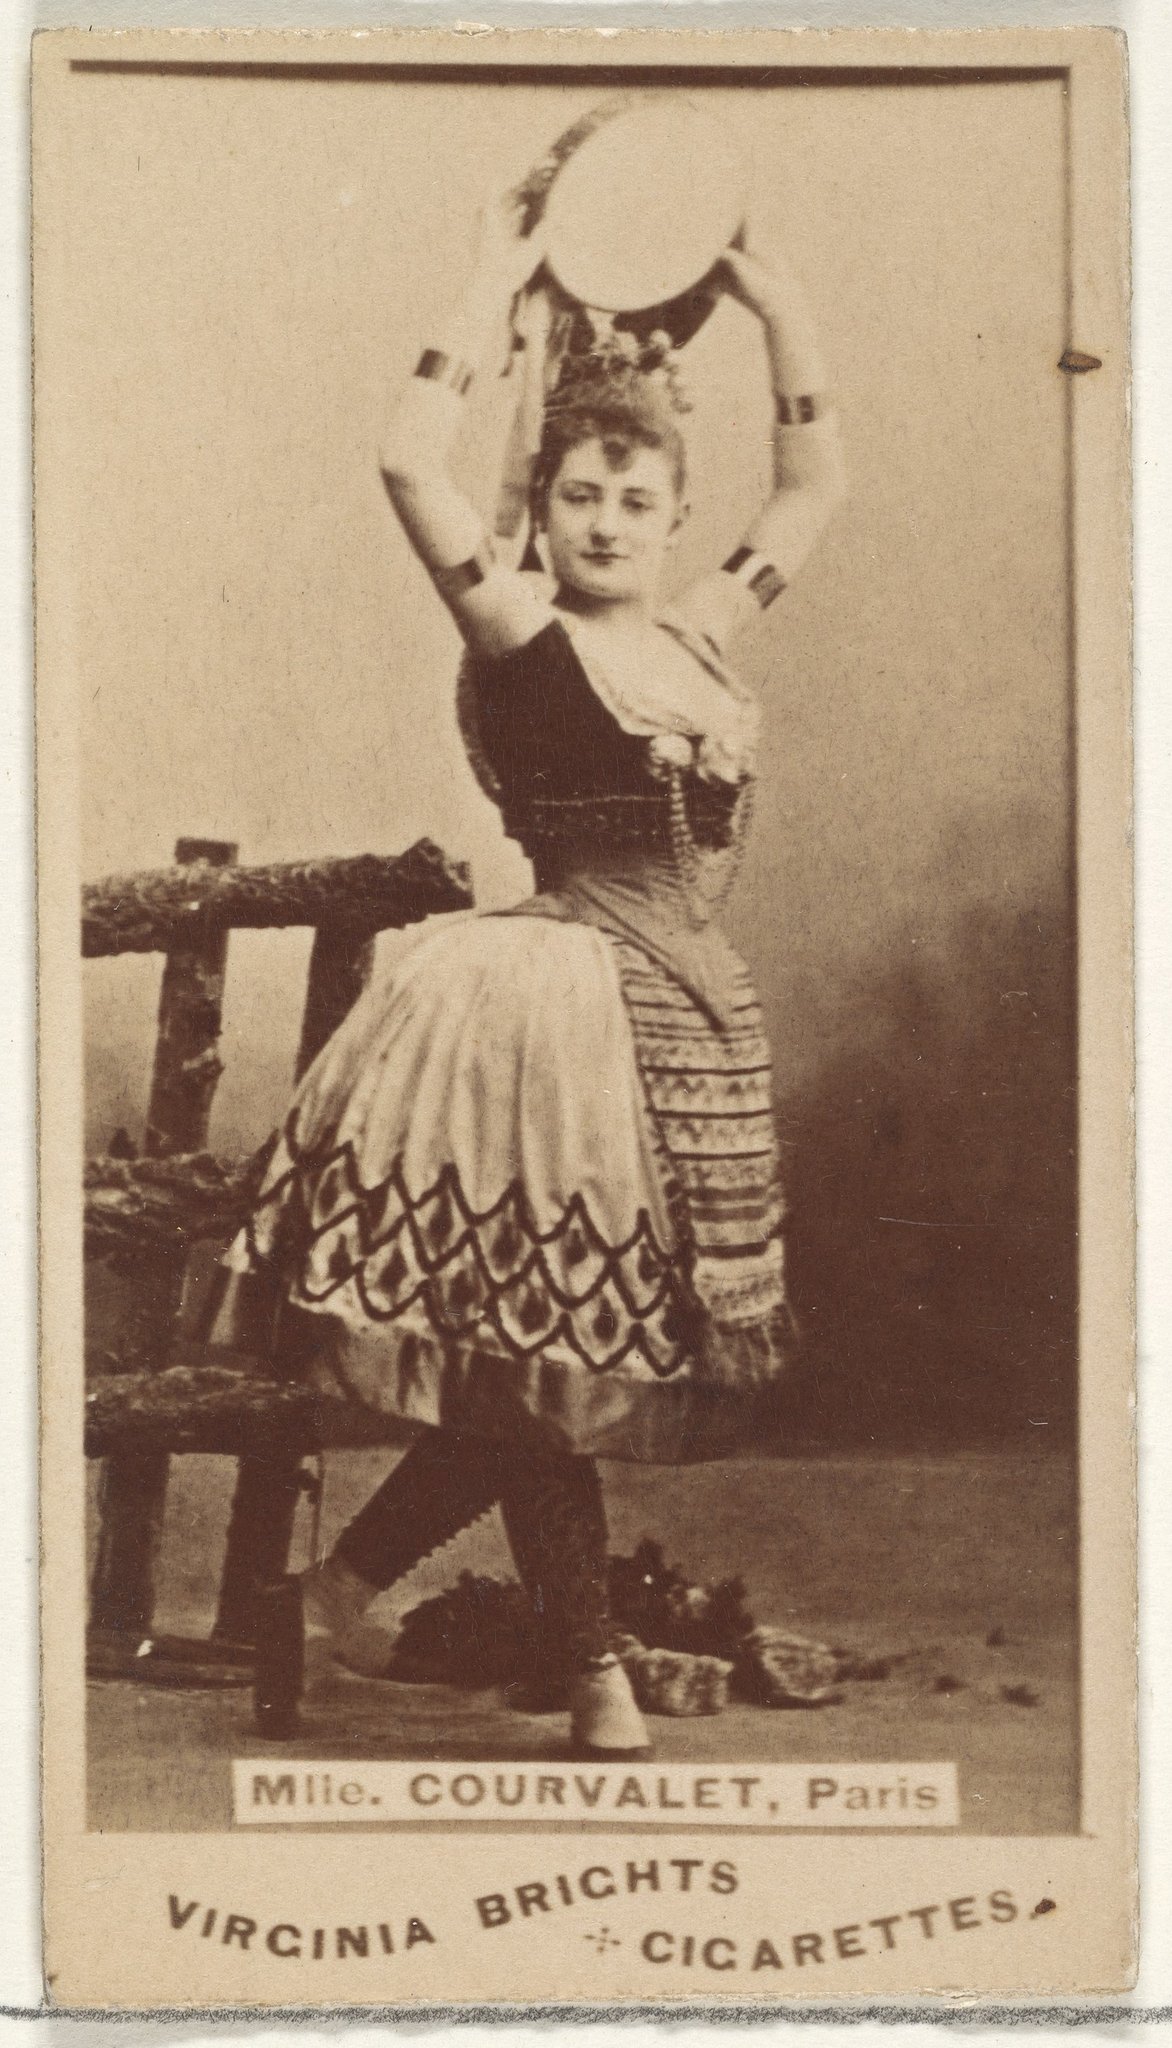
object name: photograph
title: Mlle. Courvalet, Paris, from the Actors and Actresses series (N45, Type 1) for Virginia Brights Cigarettes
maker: allen & ginter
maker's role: publisher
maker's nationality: american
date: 1888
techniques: albumen silver print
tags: portraits,women,actresses